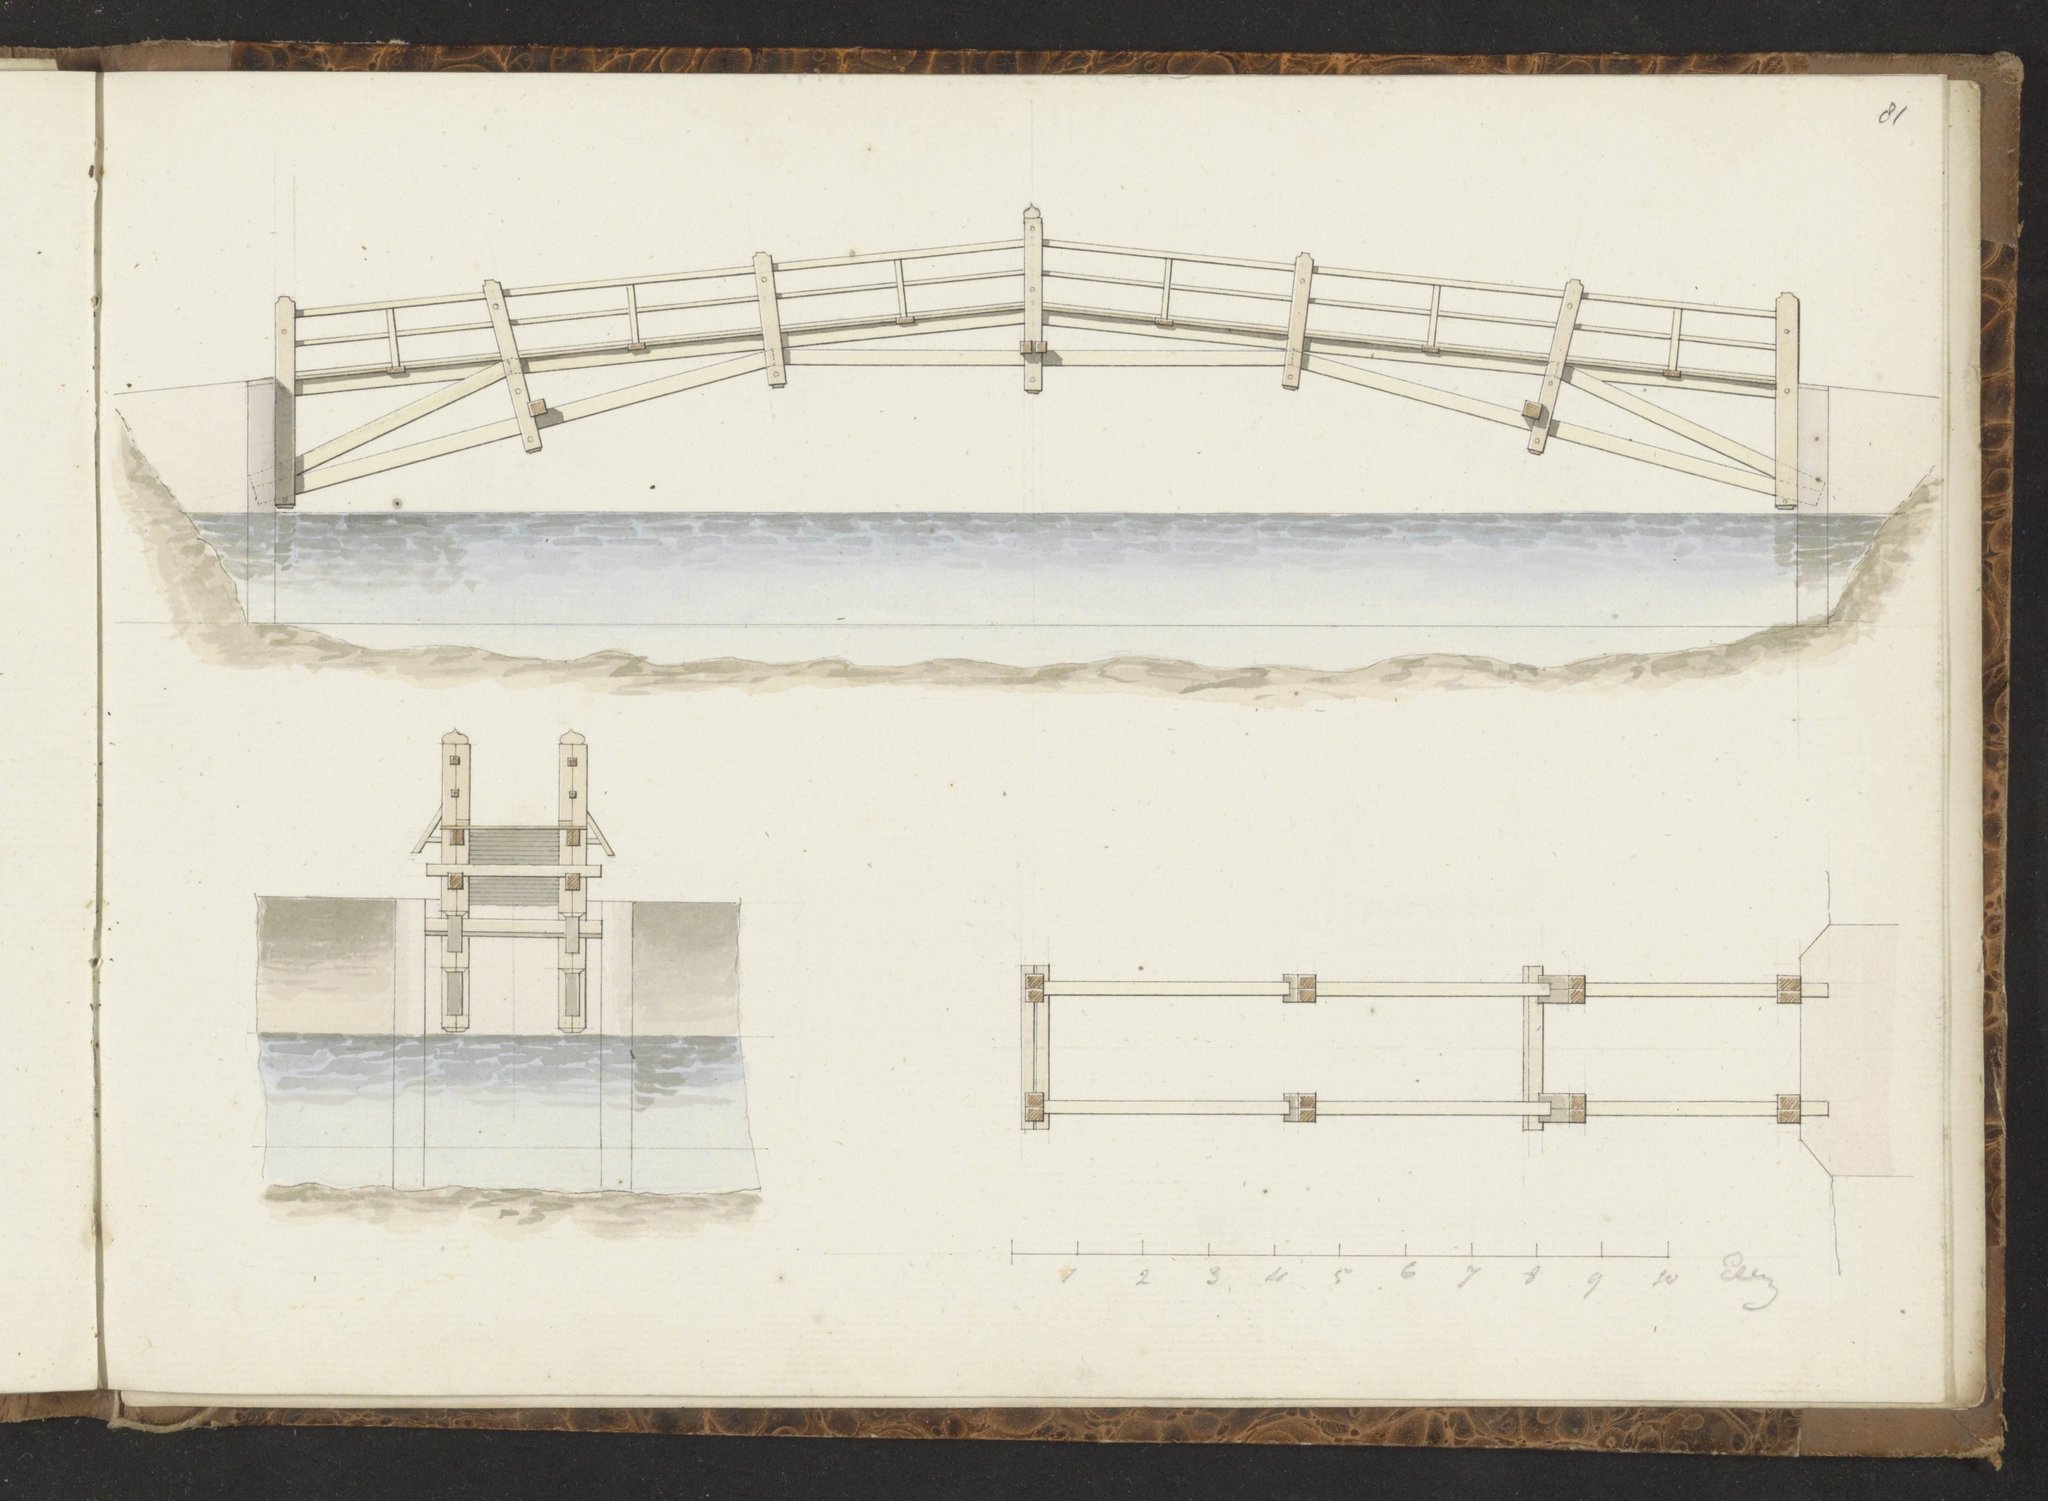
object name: sketchbook leaf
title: Brug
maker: willem springer jr.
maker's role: draughtsman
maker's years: 1815-1907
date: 1825-1907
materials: ink, paper, pencil, watercolor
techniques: brush, pen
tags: bridge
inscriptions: annotation: ‘[...]’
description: Pagina 81 uit een schetsboek met 86 pagina's.